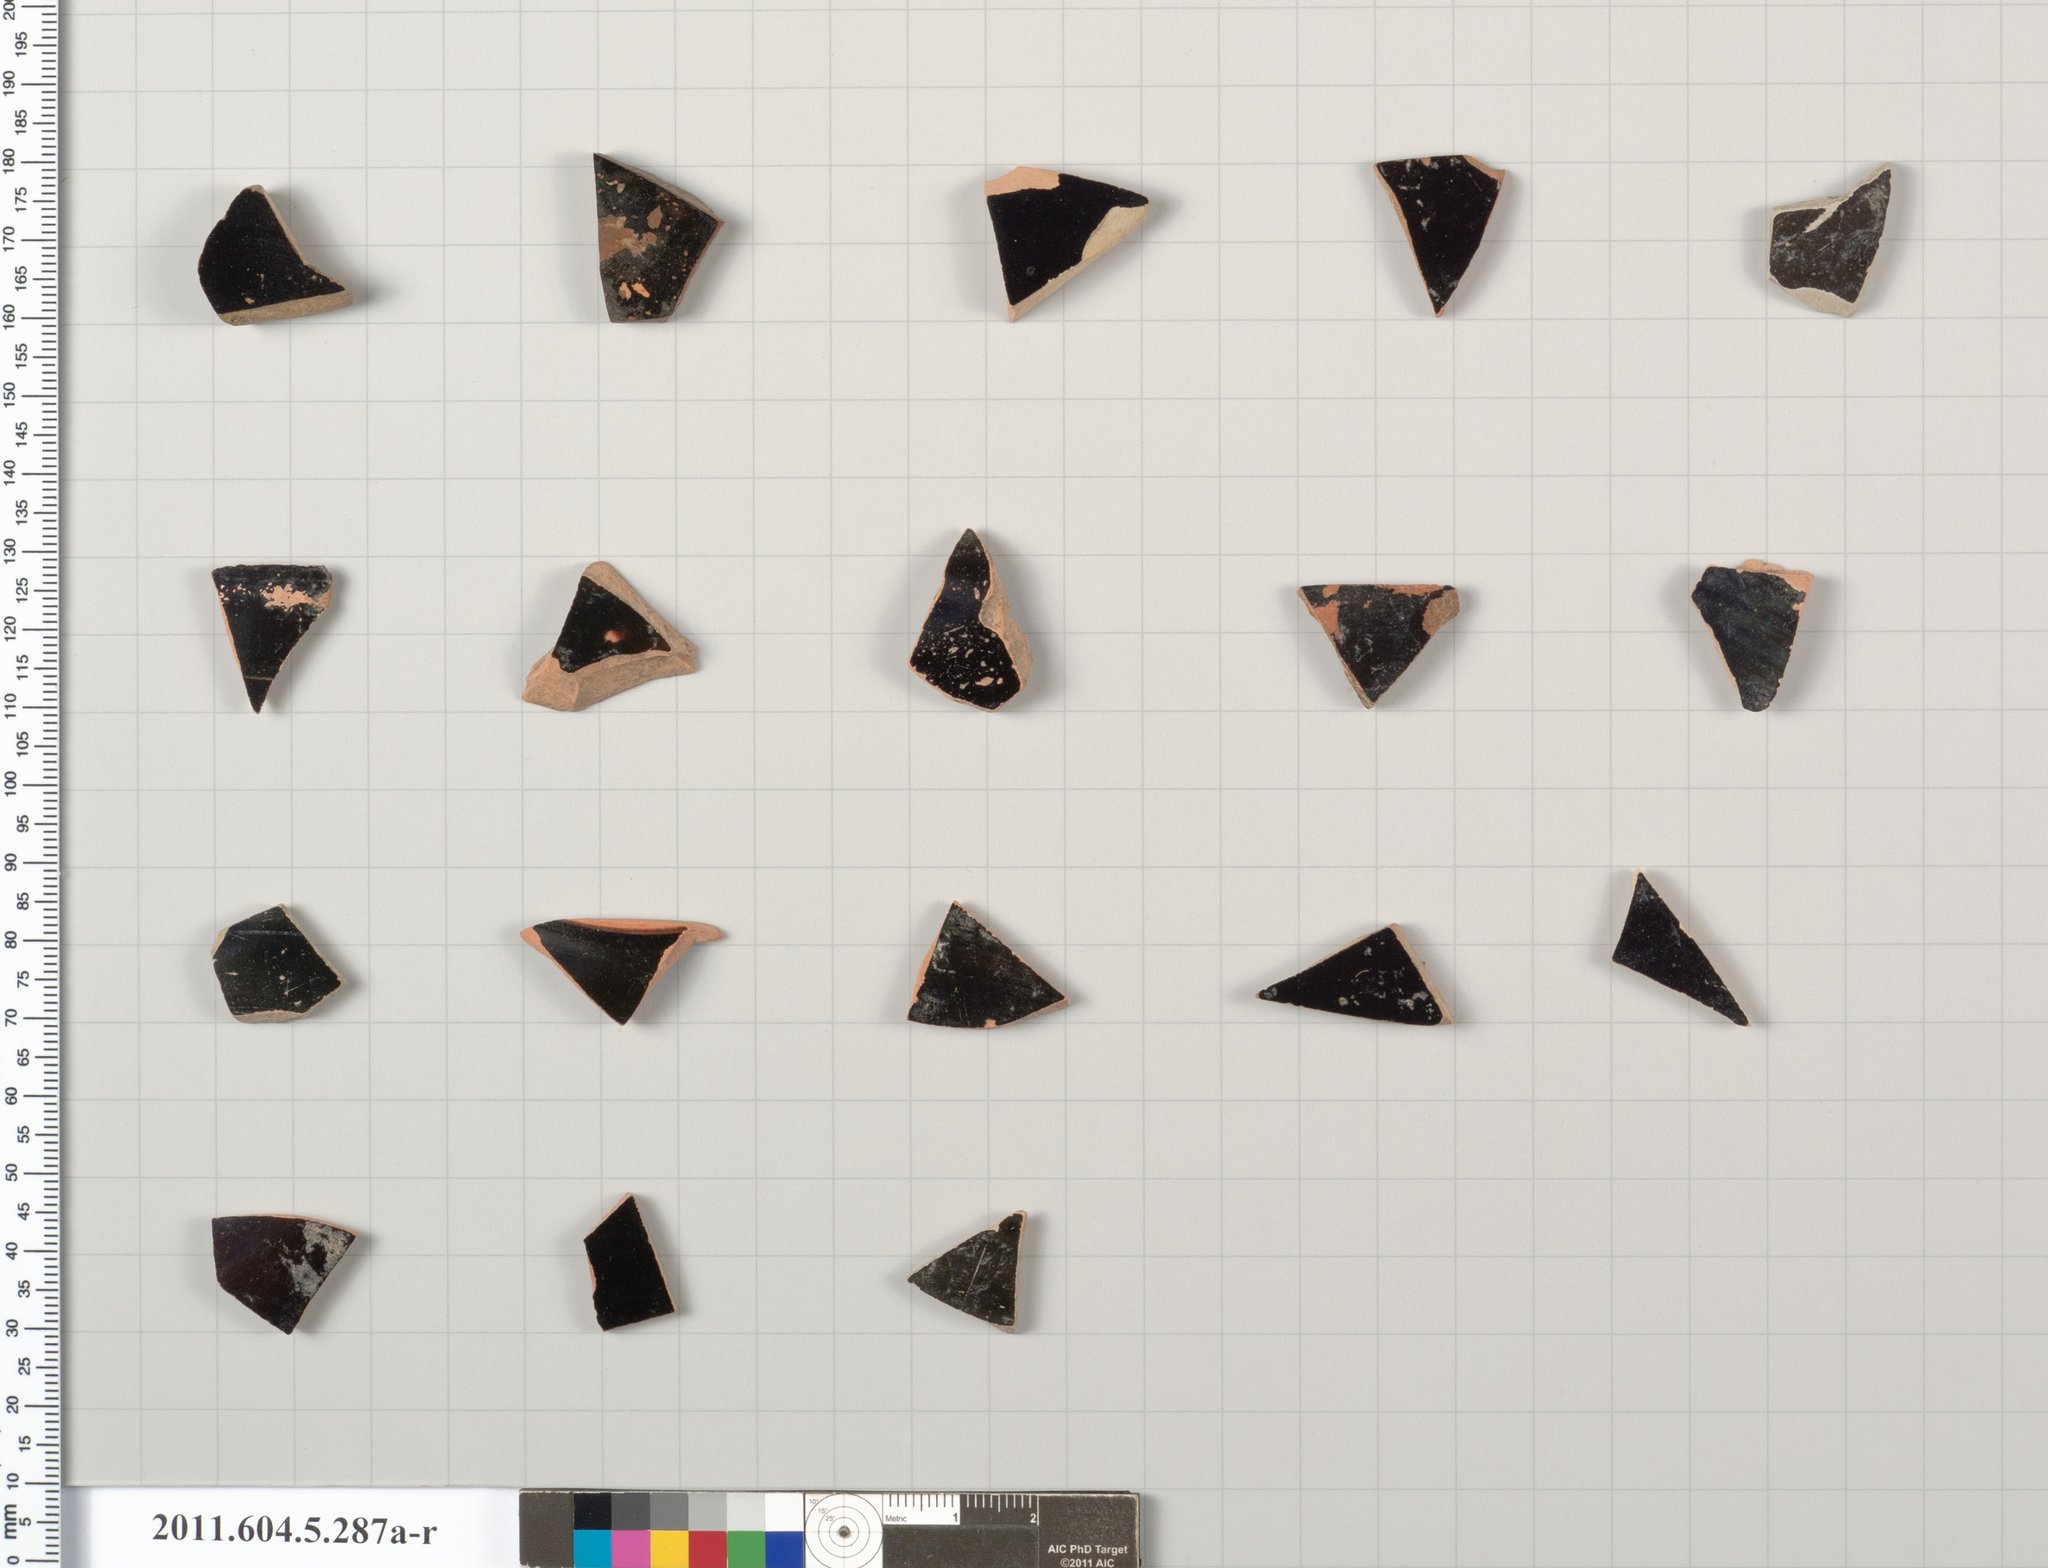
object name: kylix fragment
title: Terracotta fragments of kylikes (drinking cups)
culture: greek, attic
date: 600-401 BCE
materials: terracotta